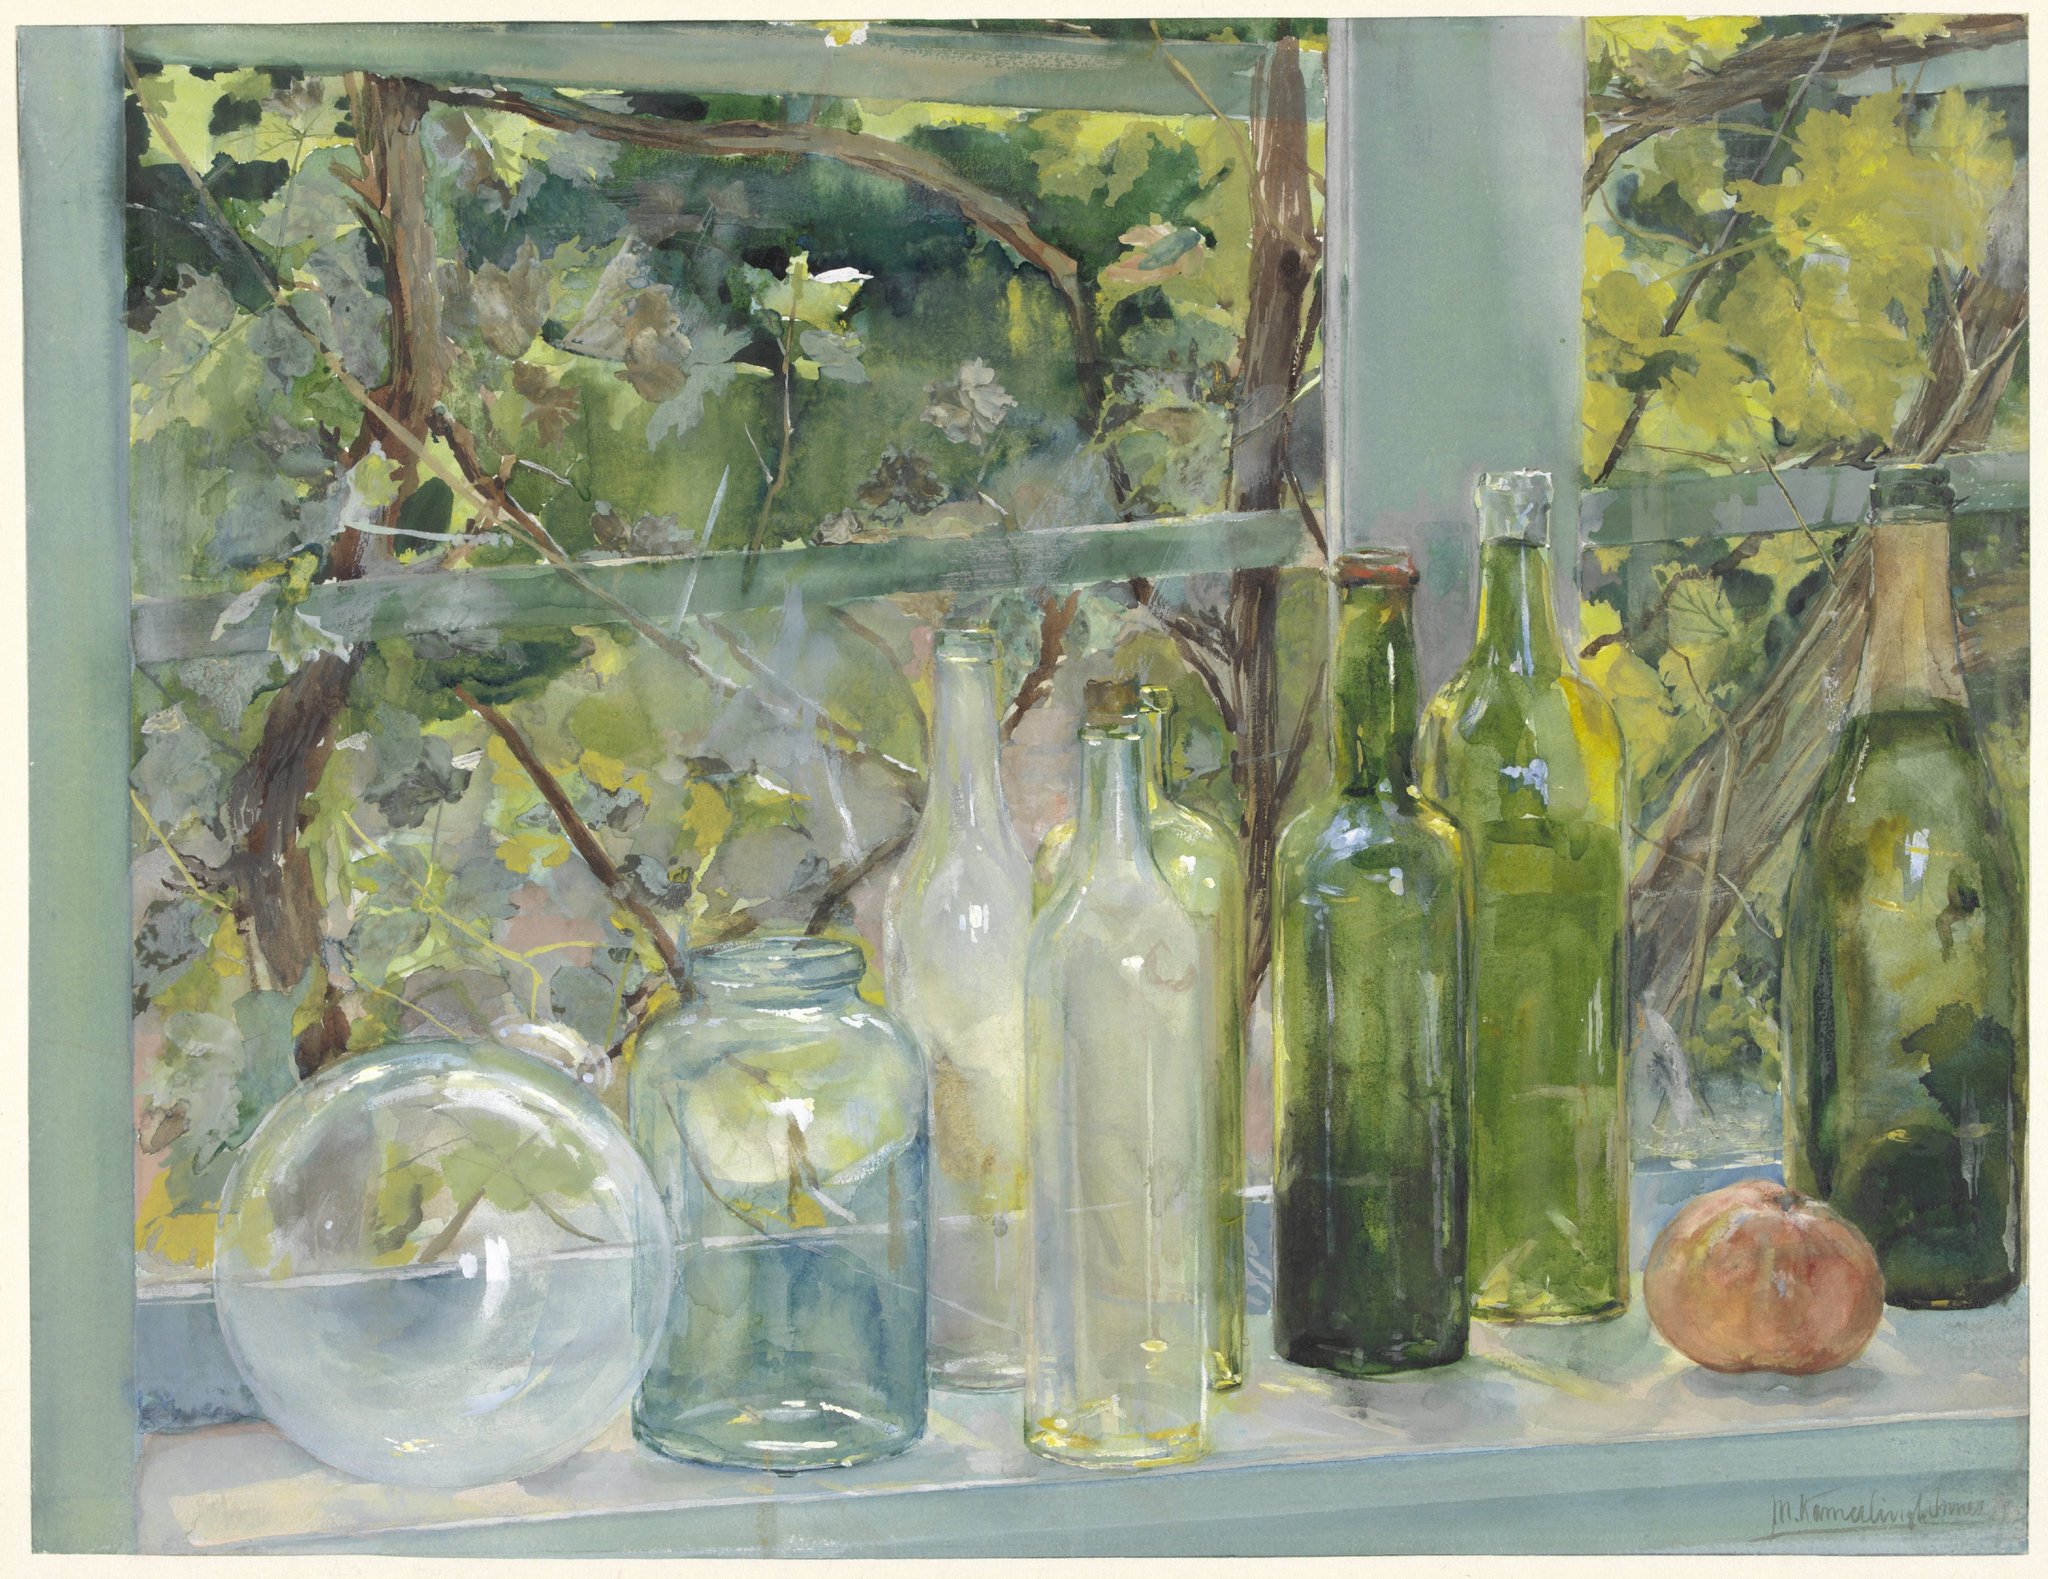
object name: watercolor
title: Windowsill with Bottles, a Glass Globe and an Apple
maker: menso kamerlingh onnes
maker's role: painter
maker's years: 1860-1925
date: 1892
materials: paint, paper, watercolor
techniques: brush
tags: fruits: apple, still life of related objects, container of glass: bottle, jar, vase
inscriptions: signature: ‘M. Kamerlingh Onnes’